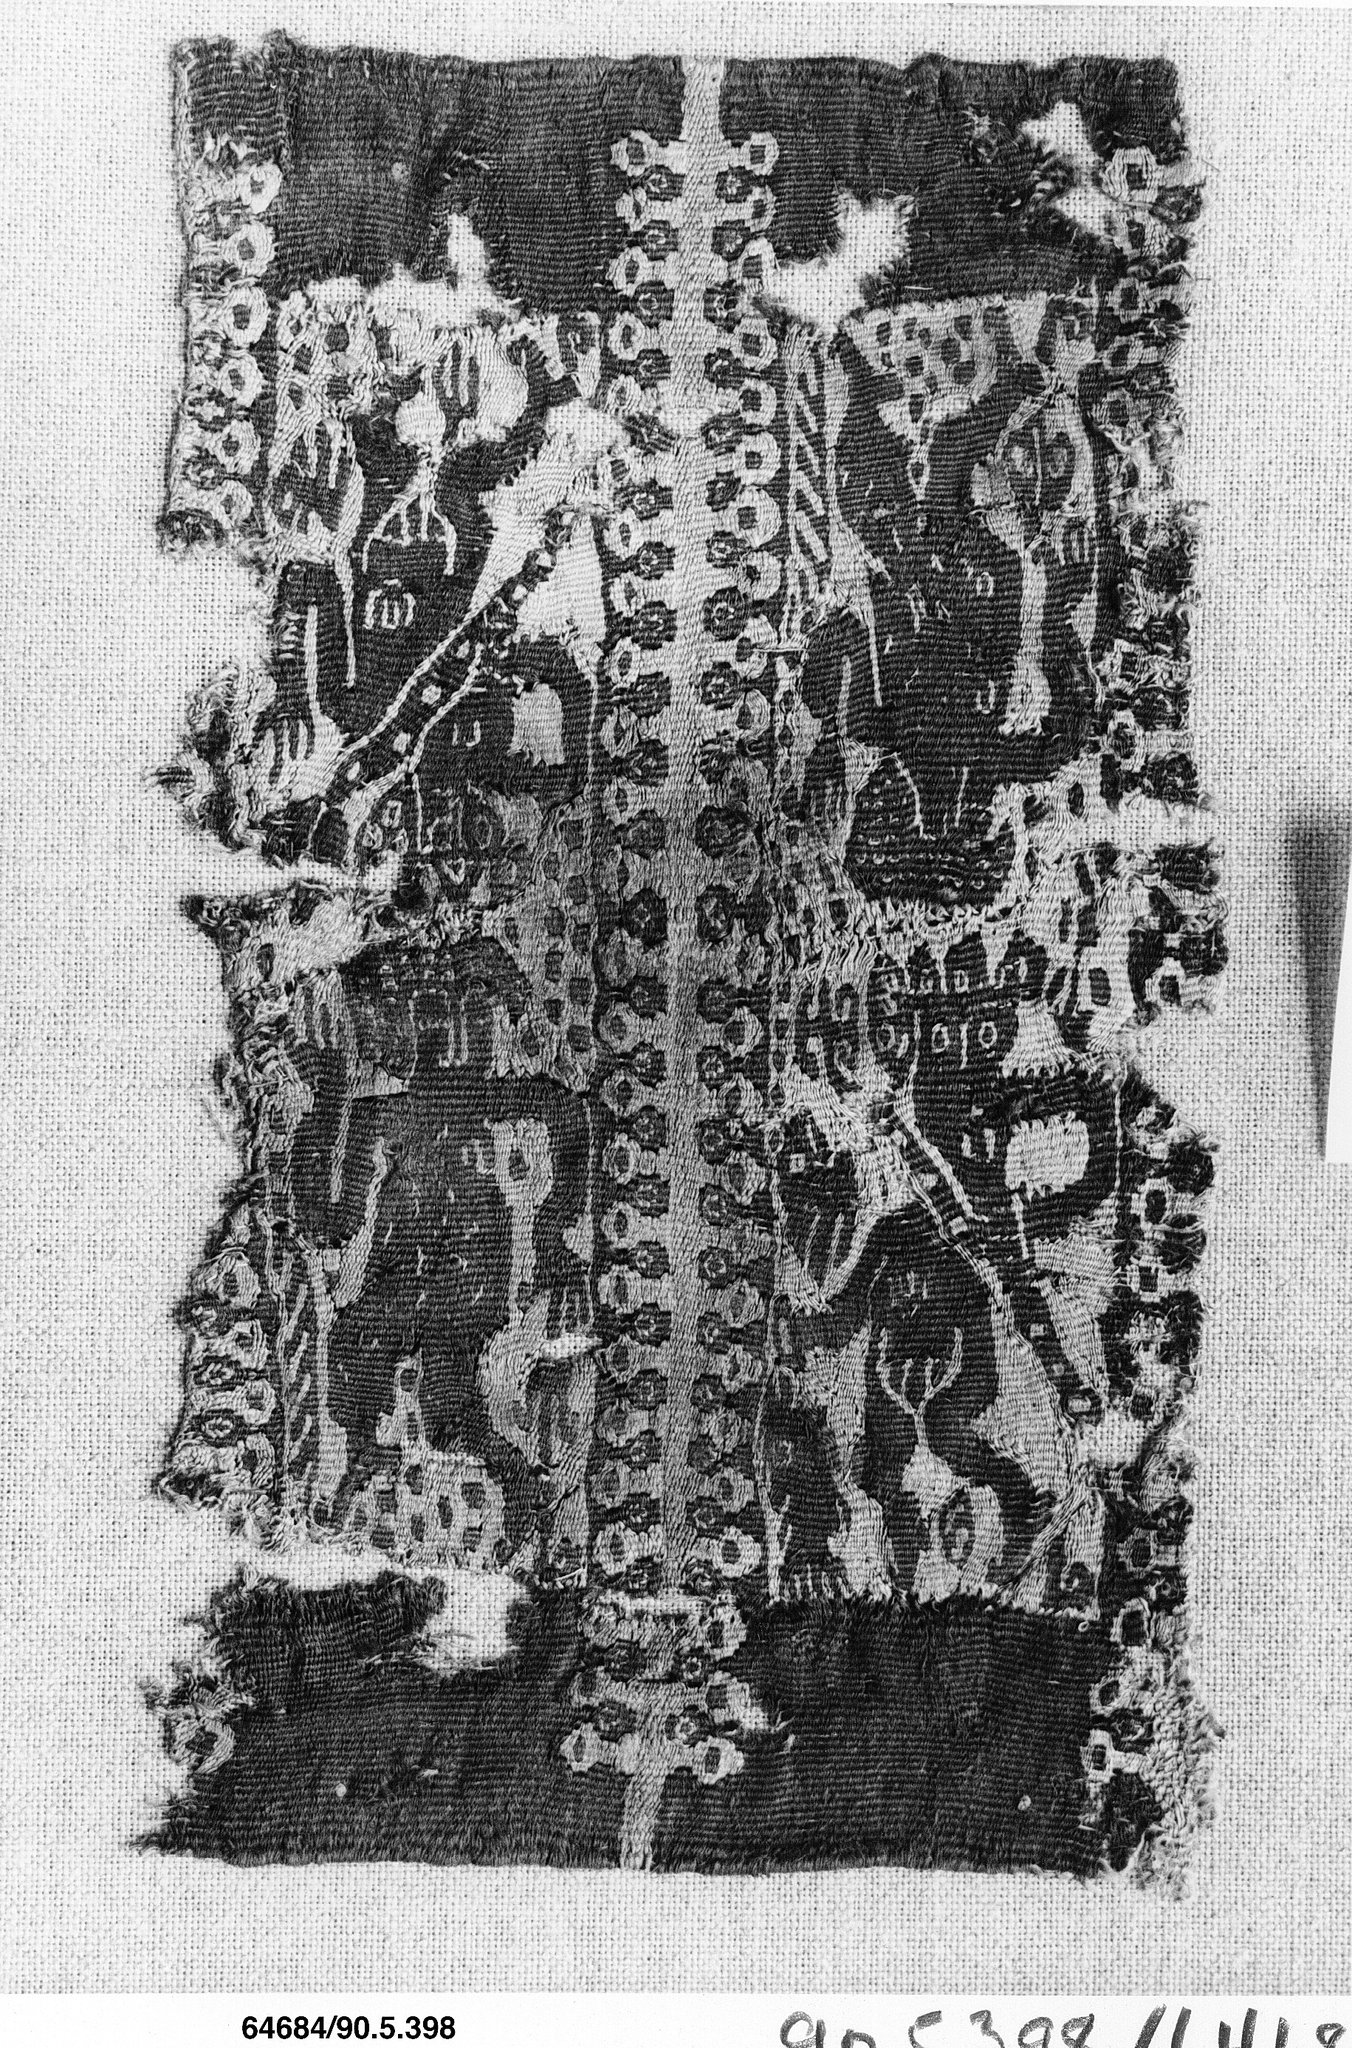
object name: textile fragment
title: Fragment of a Sleeve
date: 301-400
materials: linen, wool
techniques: weave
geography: egypt